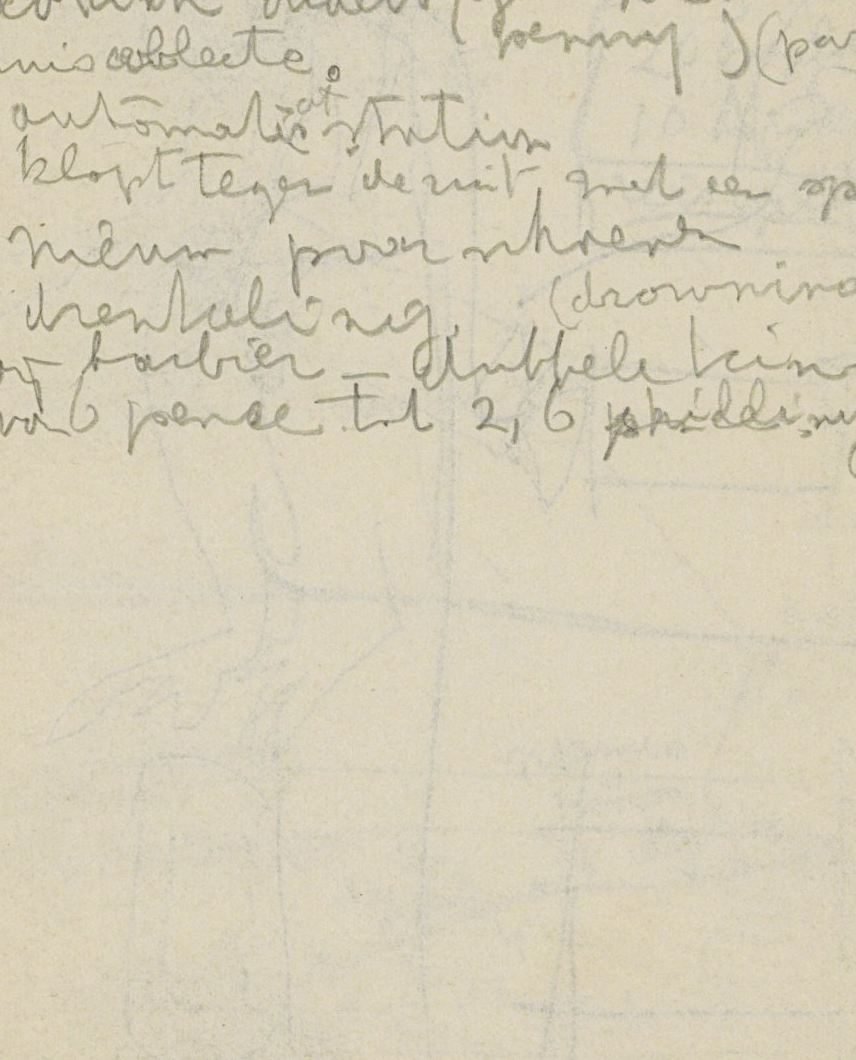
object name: sketchbook leaf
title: Notities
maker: reijer stolk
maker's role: draughtsman, print maker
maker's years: 1896-1945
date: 1916-1945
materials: paper, pencil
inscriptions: annotation: ‘vliegtuig/ dokter bezoek/ steamer from Aberdeen/ [...]’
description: Blad 60 recto uit een schetsboek met 60 bladen.